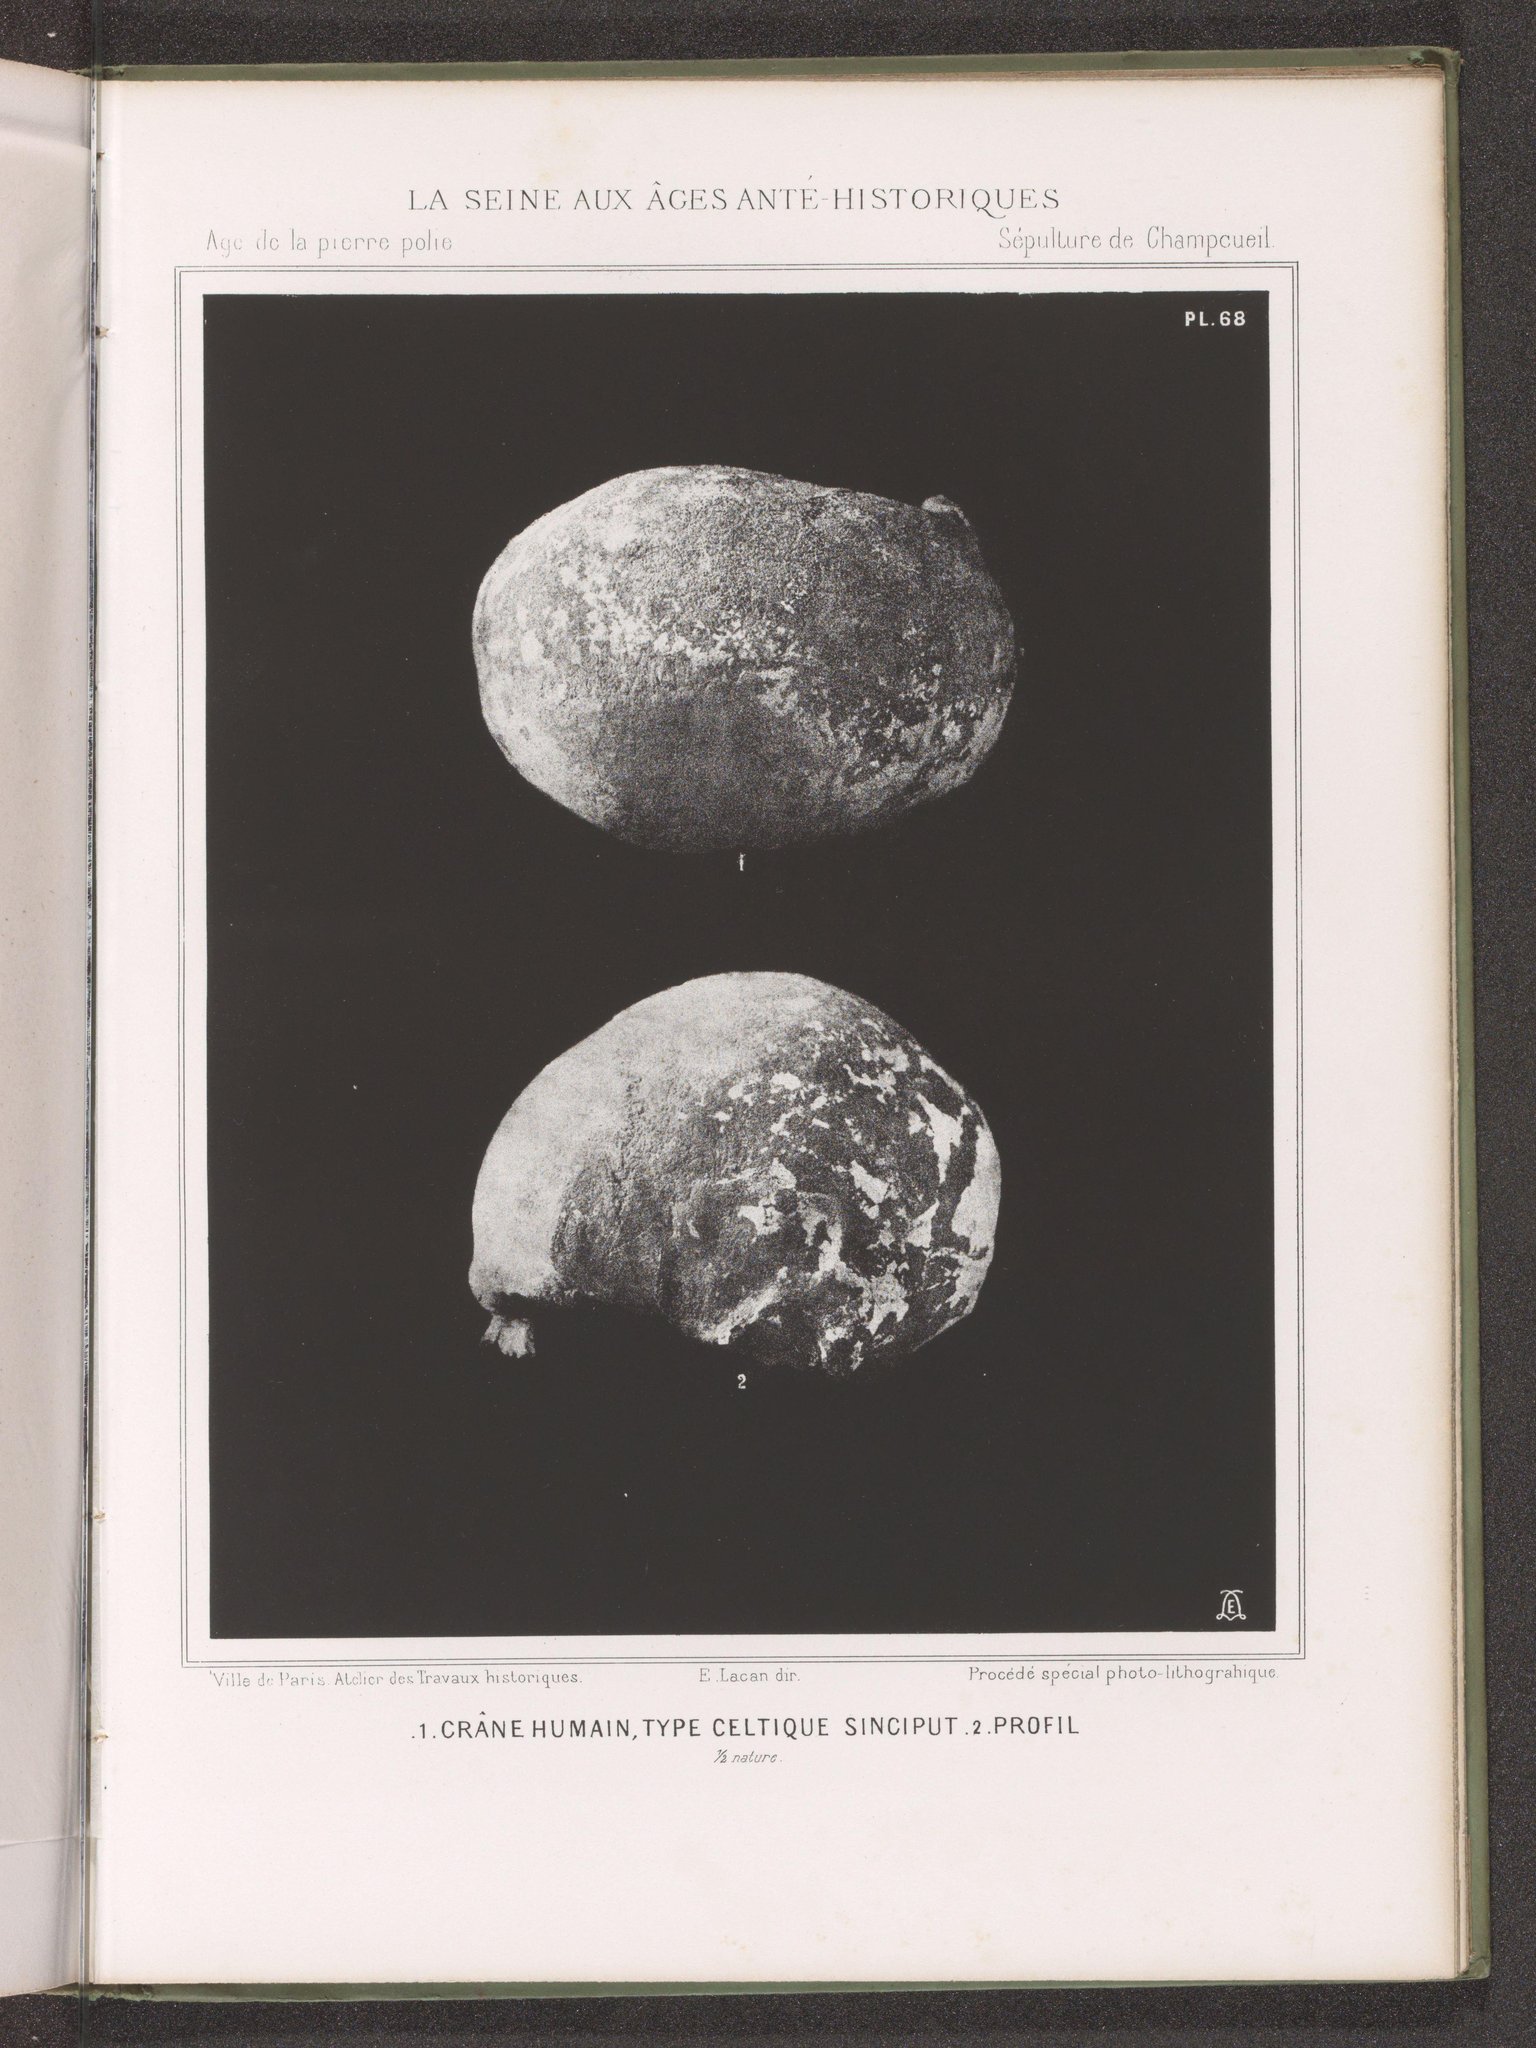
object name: page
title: Twee aanzichten van een menselijke schedel, bovenaanzicht en en profil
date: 1860-1869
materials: paper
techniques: photolithography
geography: paris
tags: animals (+ skeleton of an animal), palaeontology, france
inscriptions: number: ‘Pl. 68’, inscription: ‘Ville de Paris. Atelier des Travaux historiques. E. Lacan, dir. Procédé spécial photo-lithographique.’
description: Voor plek prent in boek: zie nummer onder 'Opschriften / Merken'.